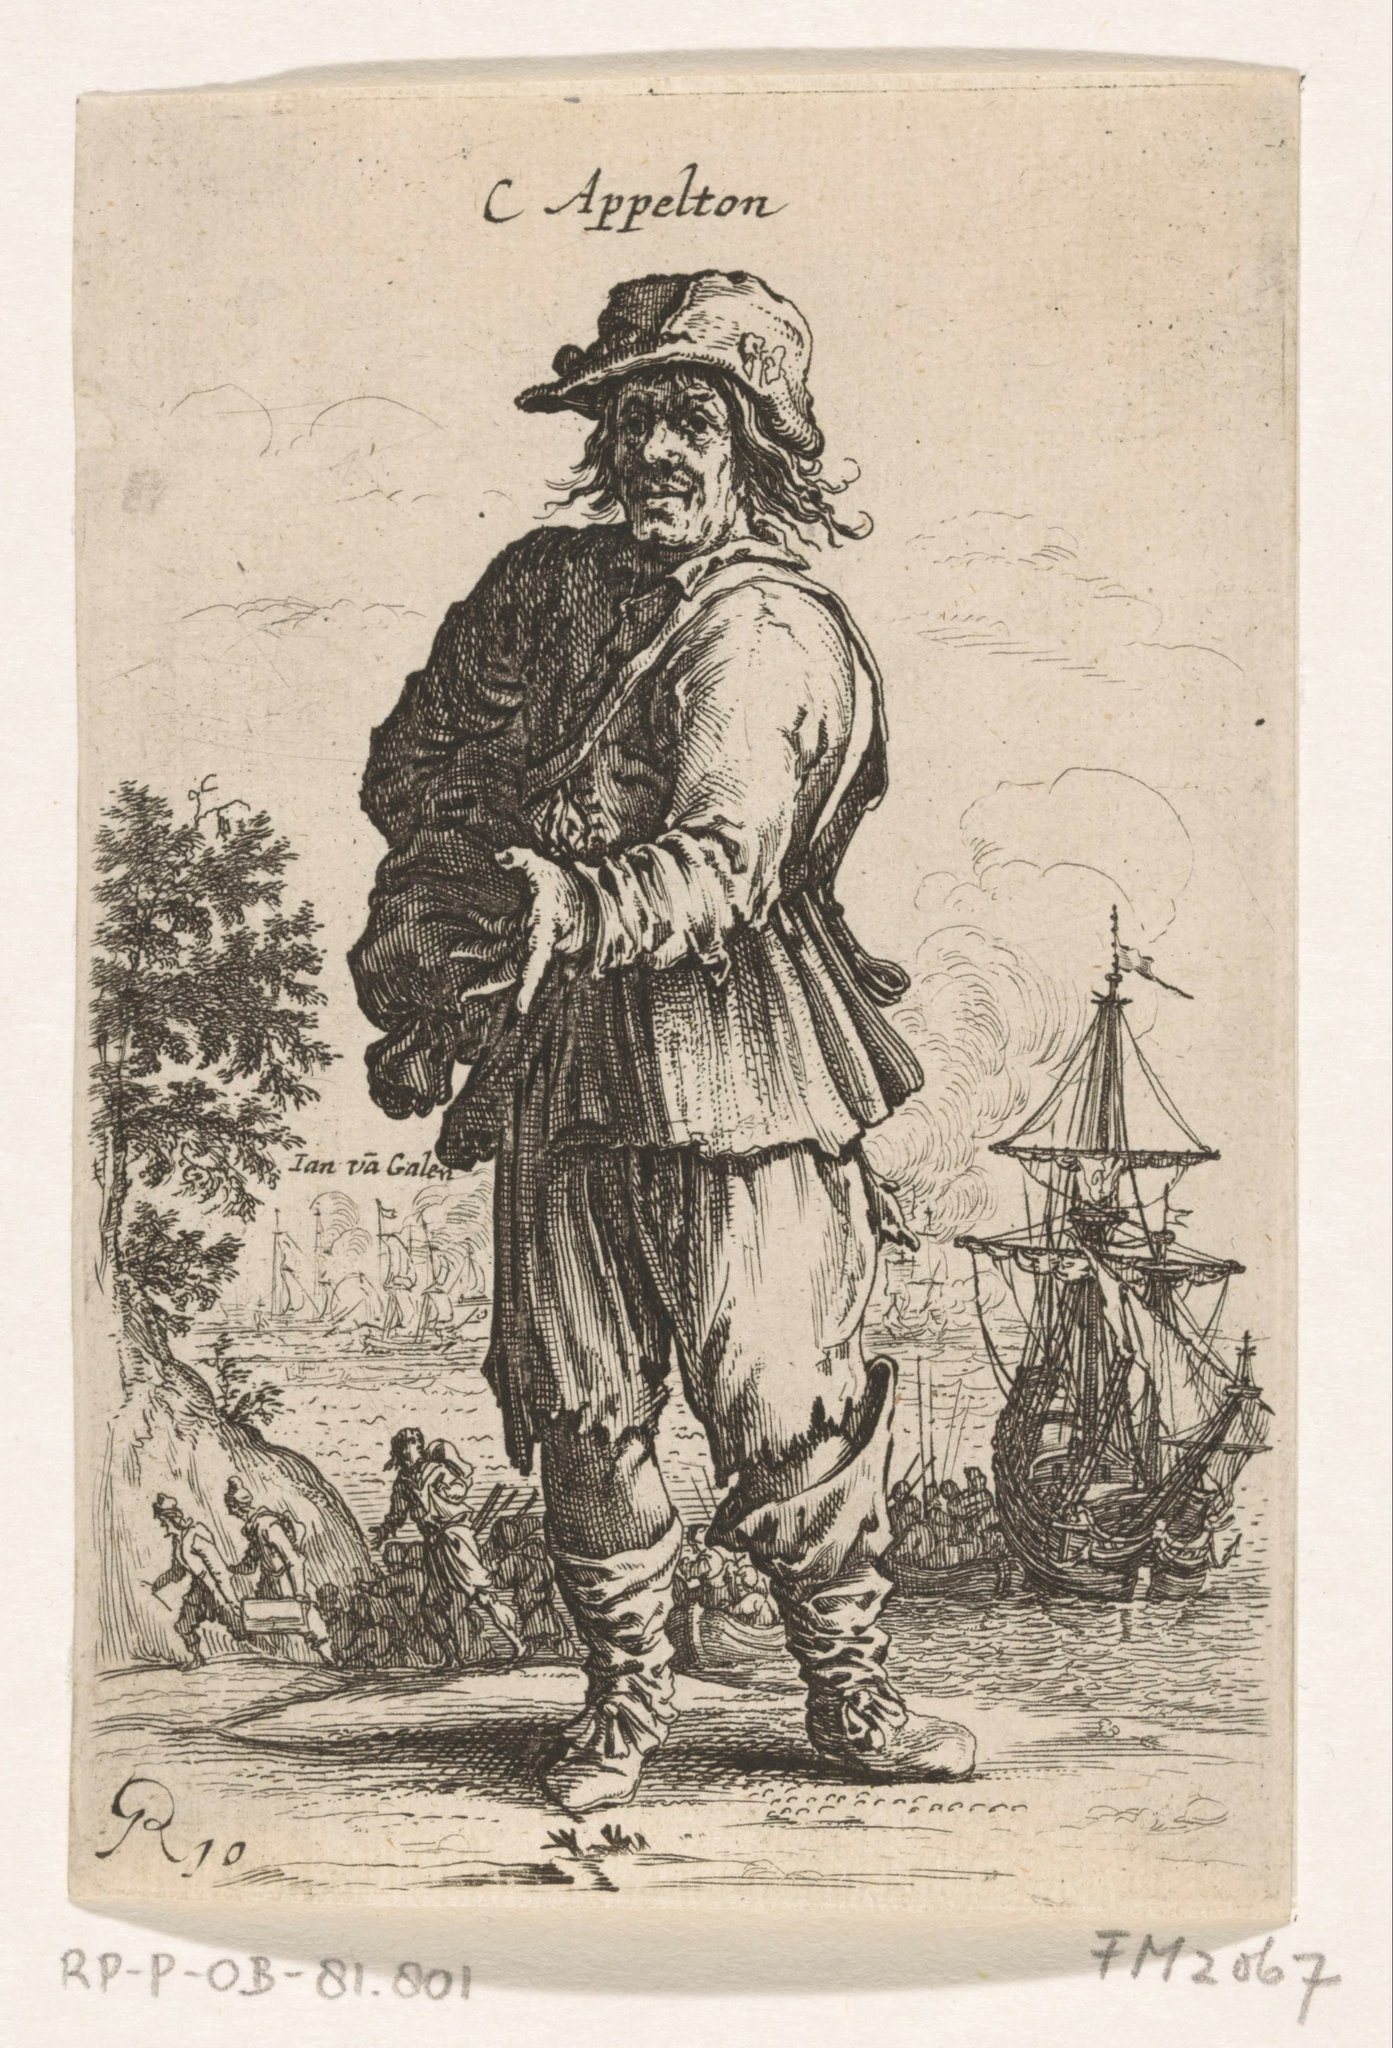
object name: print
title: Spotprent op admiraal Appleton, 1653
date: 1653-1654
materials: paper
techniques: engraving, etching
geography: northern netherlands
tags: battle of leghorn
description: Spotprent op de Engelse admiraal Henry Appleton, bevelhebber van de Engelse vloot verslagen tijdens de zeeslag bij Livorno door een Staatse vloot onder bevel van Jan van Galen, 14 maart 1653. De admiraal staat aan de wal, op de achtergrond de zeeslag met de naam van Jan van Galen. Onderdeel van een reeks kopieën naar prenten van bedelaars en boeren waarin ook verschillende ongelukkige figuren uit de Eerste Engelse Oorlog zijn opgenomen.